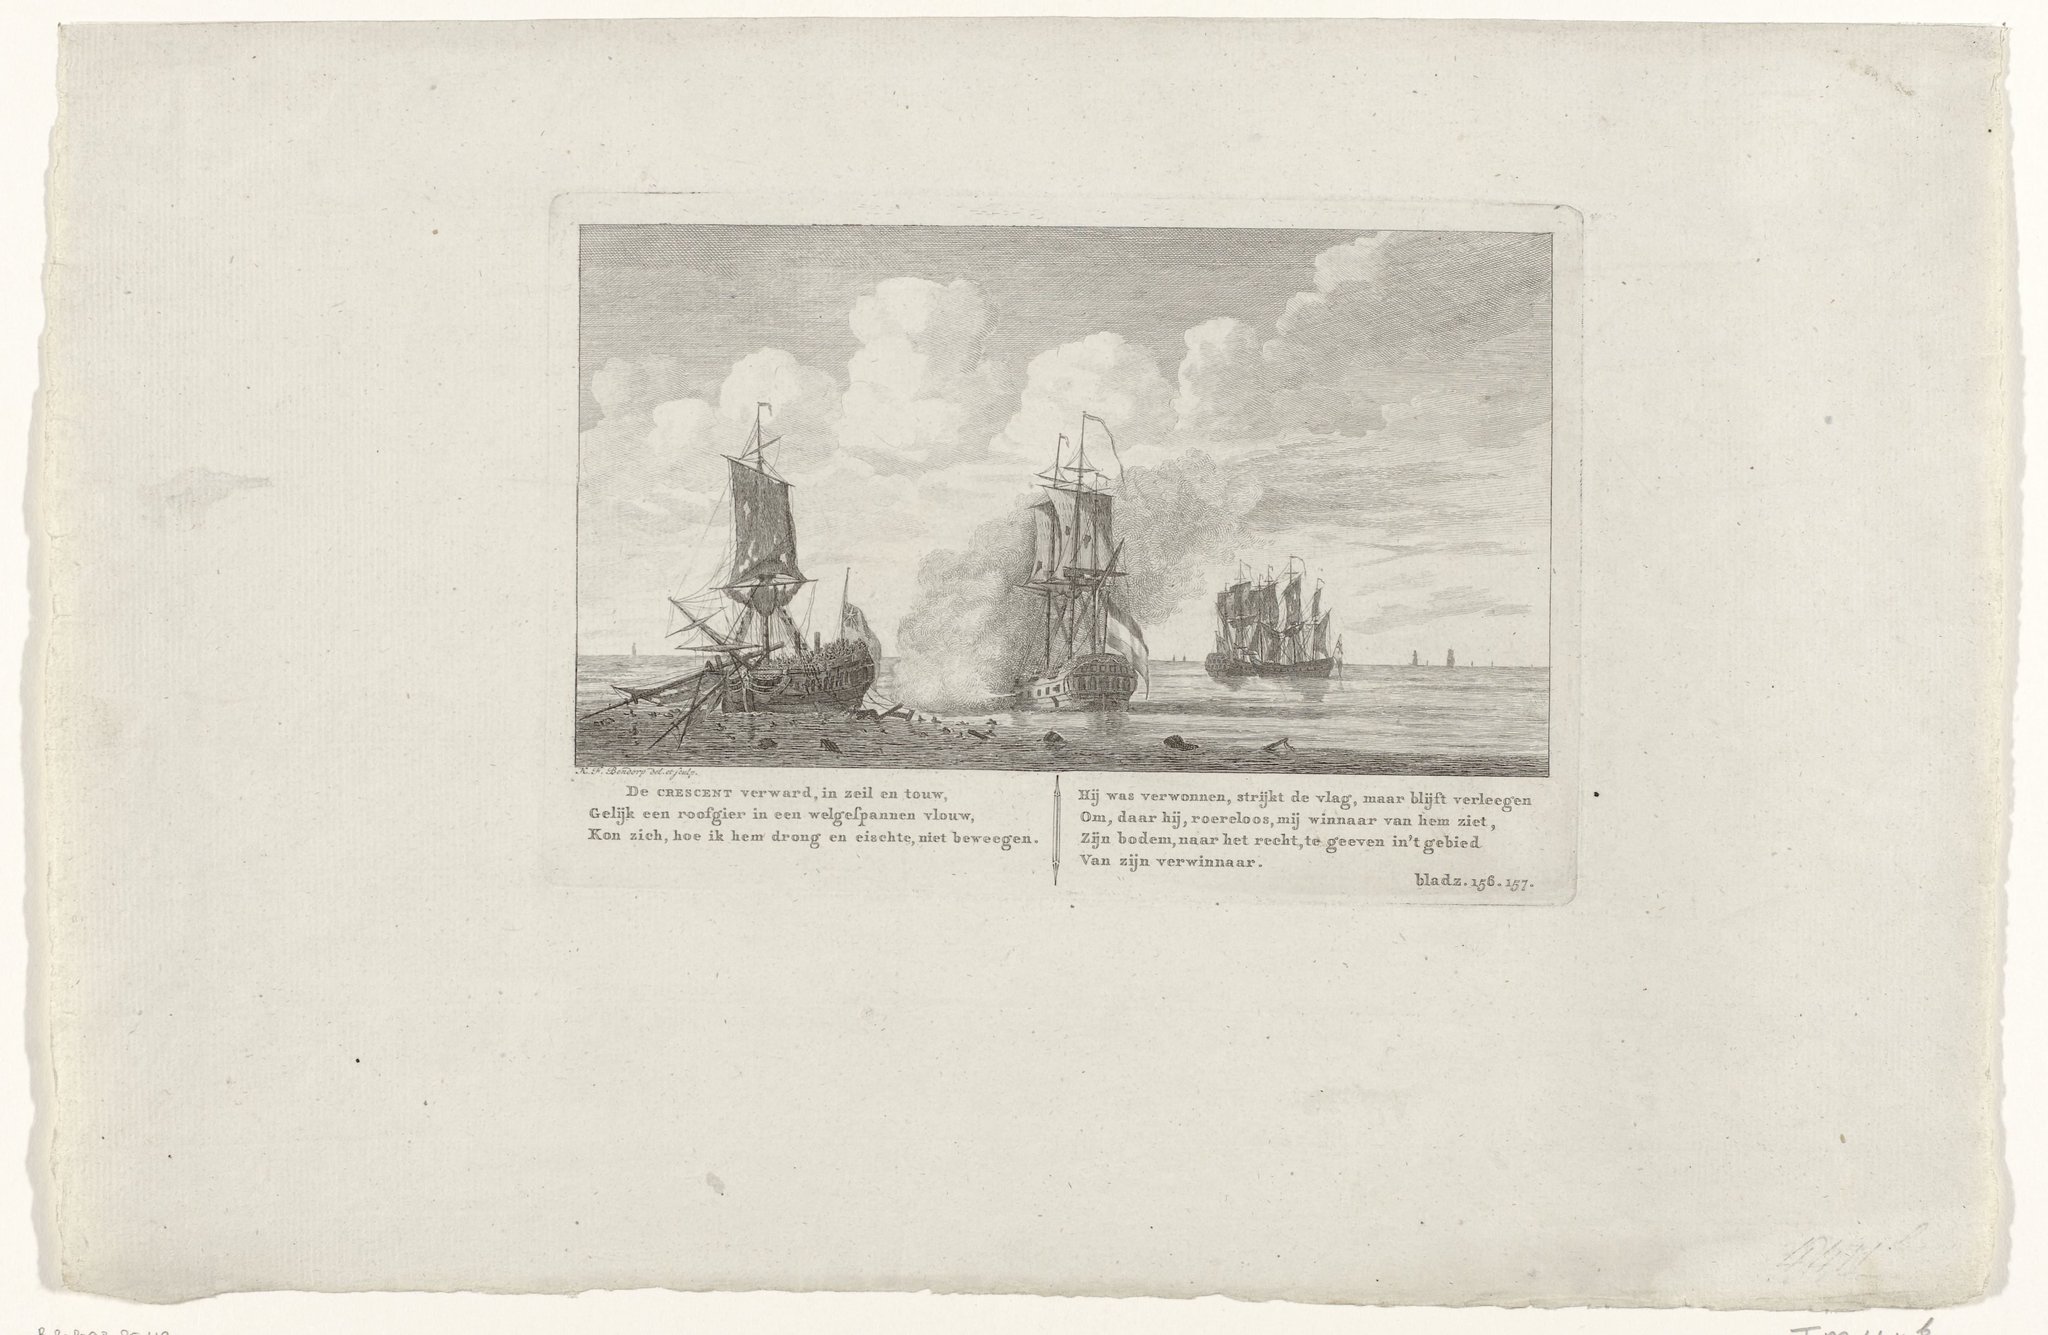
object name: print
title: Zeeslag bij Cadiz, 1781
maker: carel frederik bendorp (i)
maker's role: print maker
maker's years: 1736-1814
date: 1781-1782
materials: paper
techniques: engraving, etching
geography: northern netherlands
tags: dordrecht, the hague, naval officer, pieter melvill van carnbee, rotterdam, gerardus oorthuys, battle (+ naval force)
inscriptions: collector's mark: Lugt 2228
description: Zeegevecht bij Cadiz tussen twee Nederlandse fregatten Castor en Den Briel en twee Engelse fregatten Flora en Crescent, 30 mei 1781. Het Engelse schip Crescent reddeloos geschoten door het Nederandse fregat Briel onder bevel van Gerardus Oosthuys, op de achtergrond de twee andere schepen. In het onderschrift een zevenregelig vers en de verwijzing naar blz. 156-157.